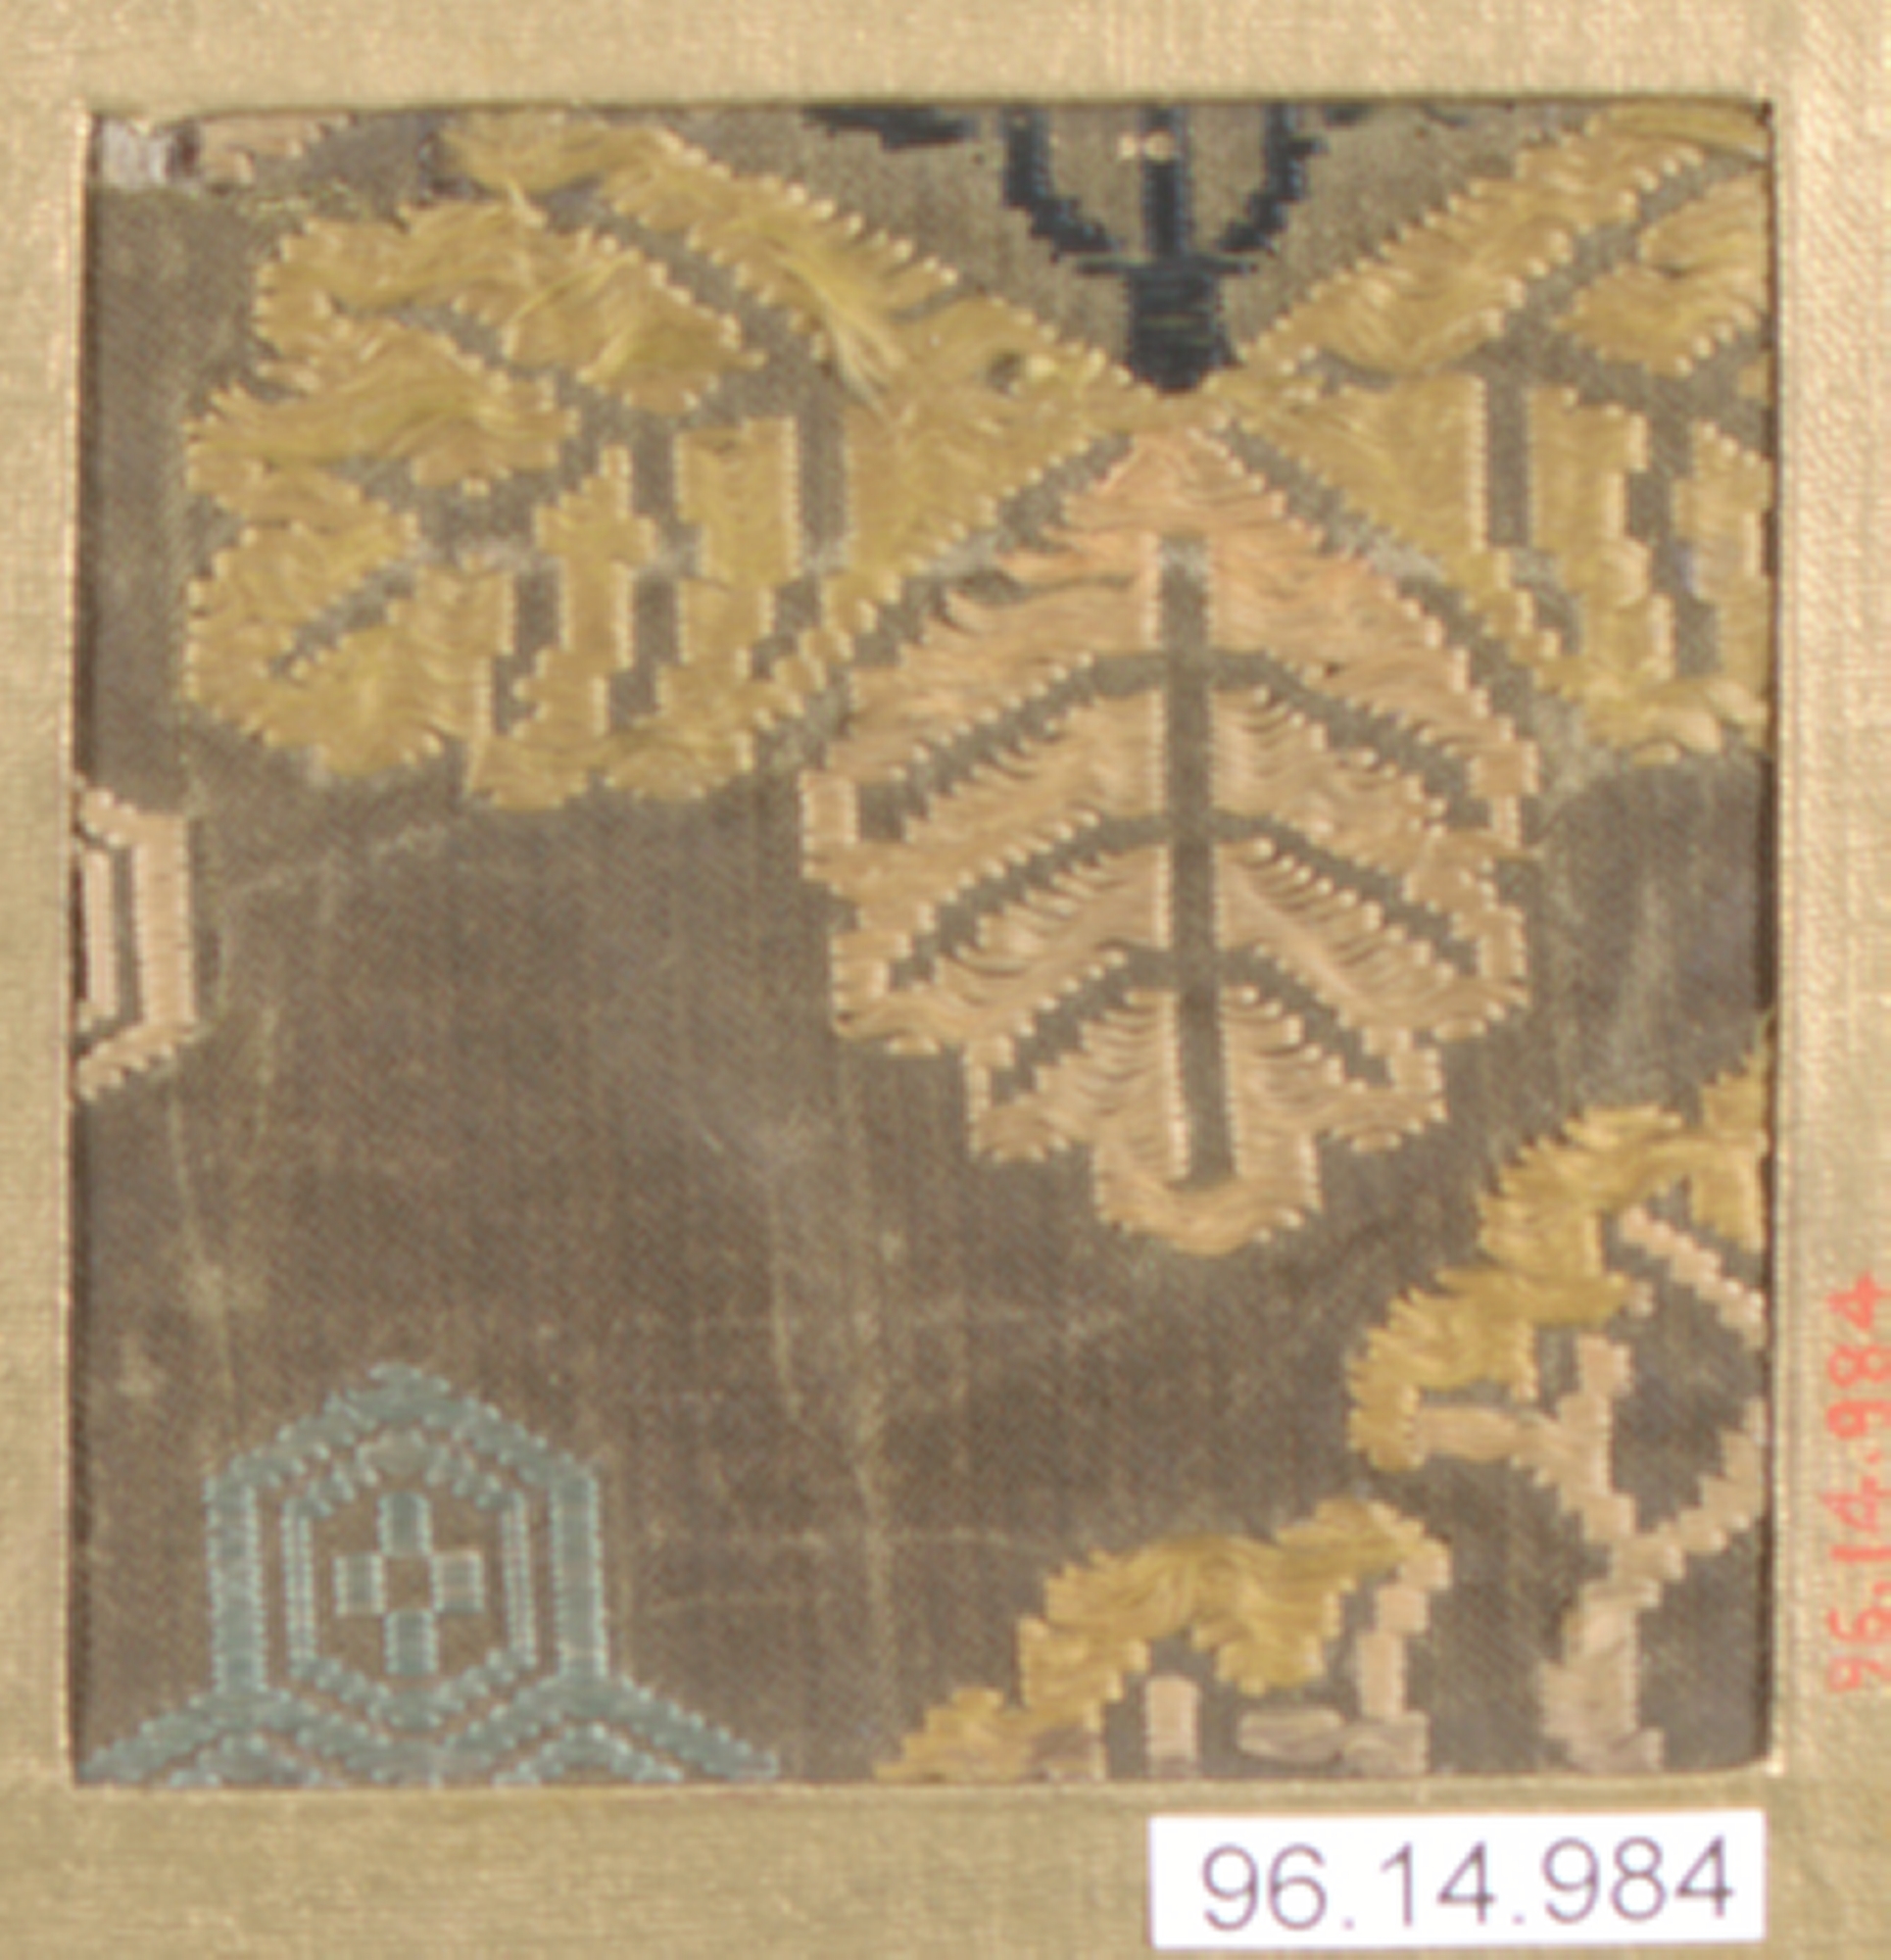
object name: piece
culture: japanese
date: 1701-1900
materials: silk